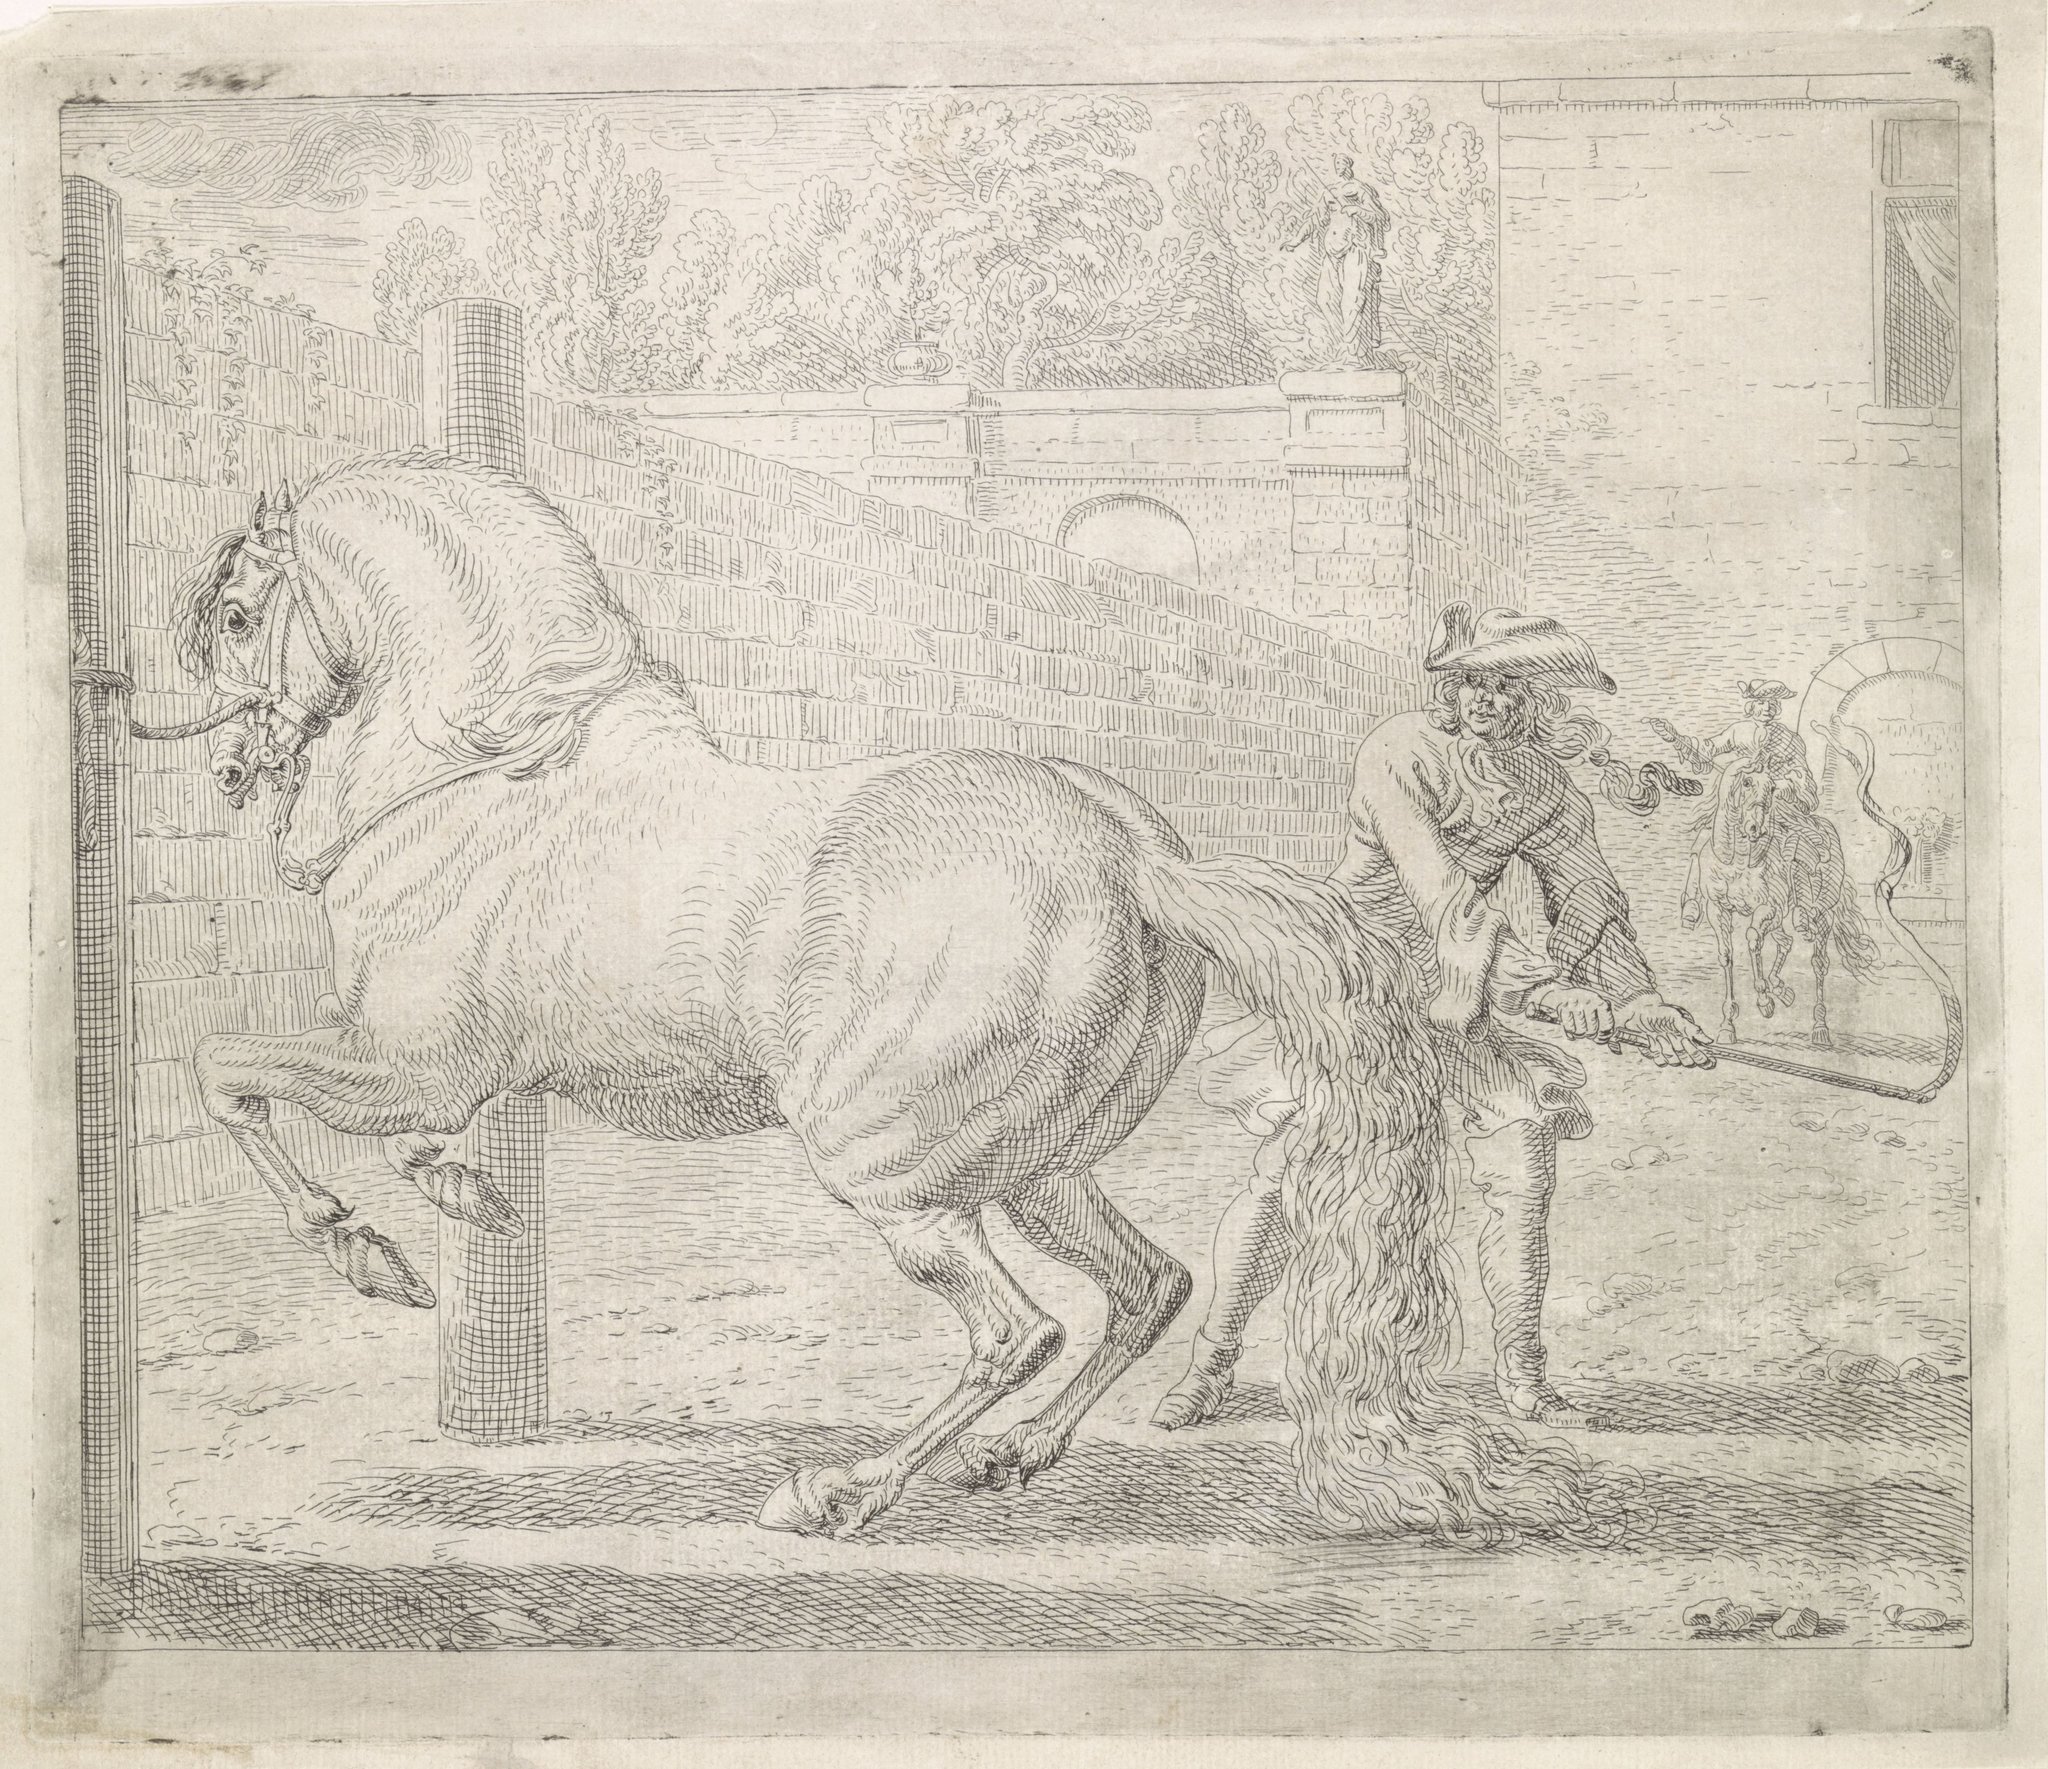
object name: print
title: Manege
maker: dirk maas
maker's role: draughtsman, print maker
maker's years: 1659-1717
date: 1669-1717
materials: paper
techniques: etching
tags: training of horses, horse, riding-school, manège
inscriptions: collector's mark: Lugt 2228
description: Man met een zweep bij een paard dat is vastgebonden aan een paal, op een binnenplaats. Prent uit een serie van negen prenten met onderwerp de manege.